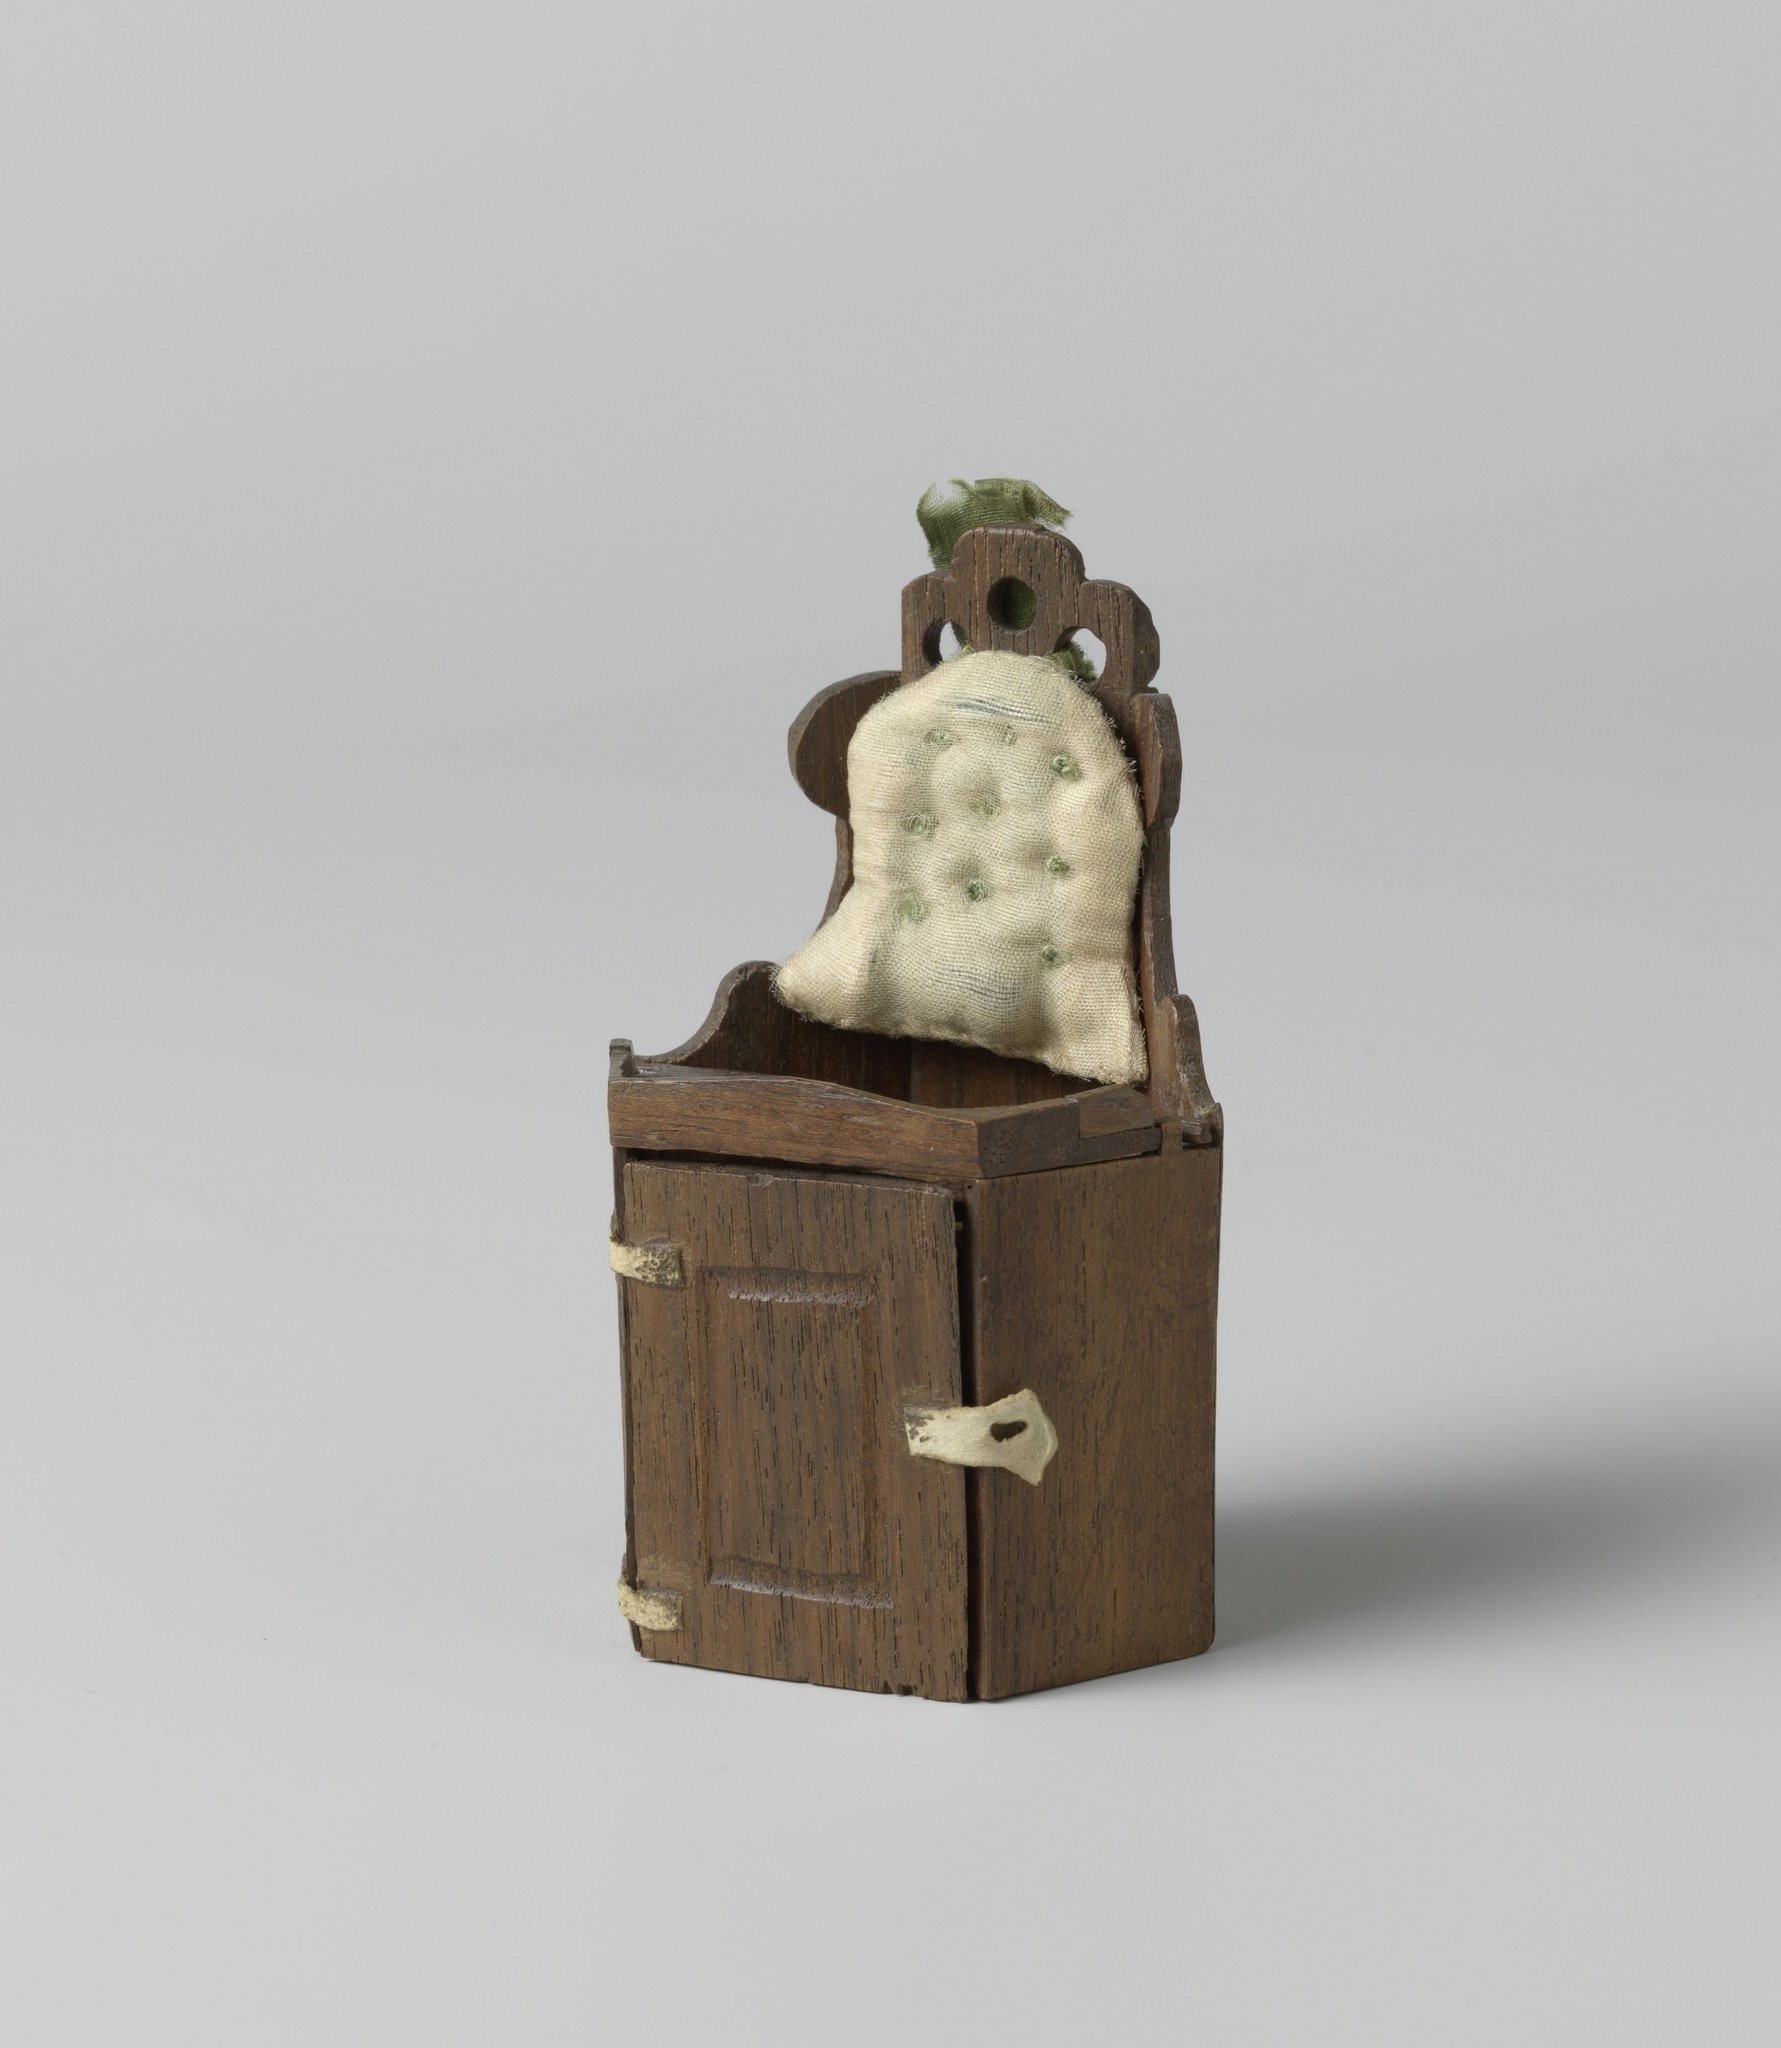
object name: kinderkakstoel, kakstoel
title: Kinderkakstoel, zeshoekig, met groen kussen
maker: Anonymous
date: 1700-1799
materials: leather, silk, wood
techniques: tufting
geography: amsterdam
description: Kinderkakstoel van notenhout. Zeskantig model met een hoge rug, los tafelblad, zitting met pottegat en een lichtgroen gecapitonneerd rugkussen